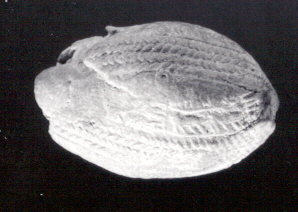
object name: sealing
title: Sealing with stamp seal impression: geometric designs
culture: assyrian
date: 1800-1701 BCE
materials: ceramic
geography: anatolia